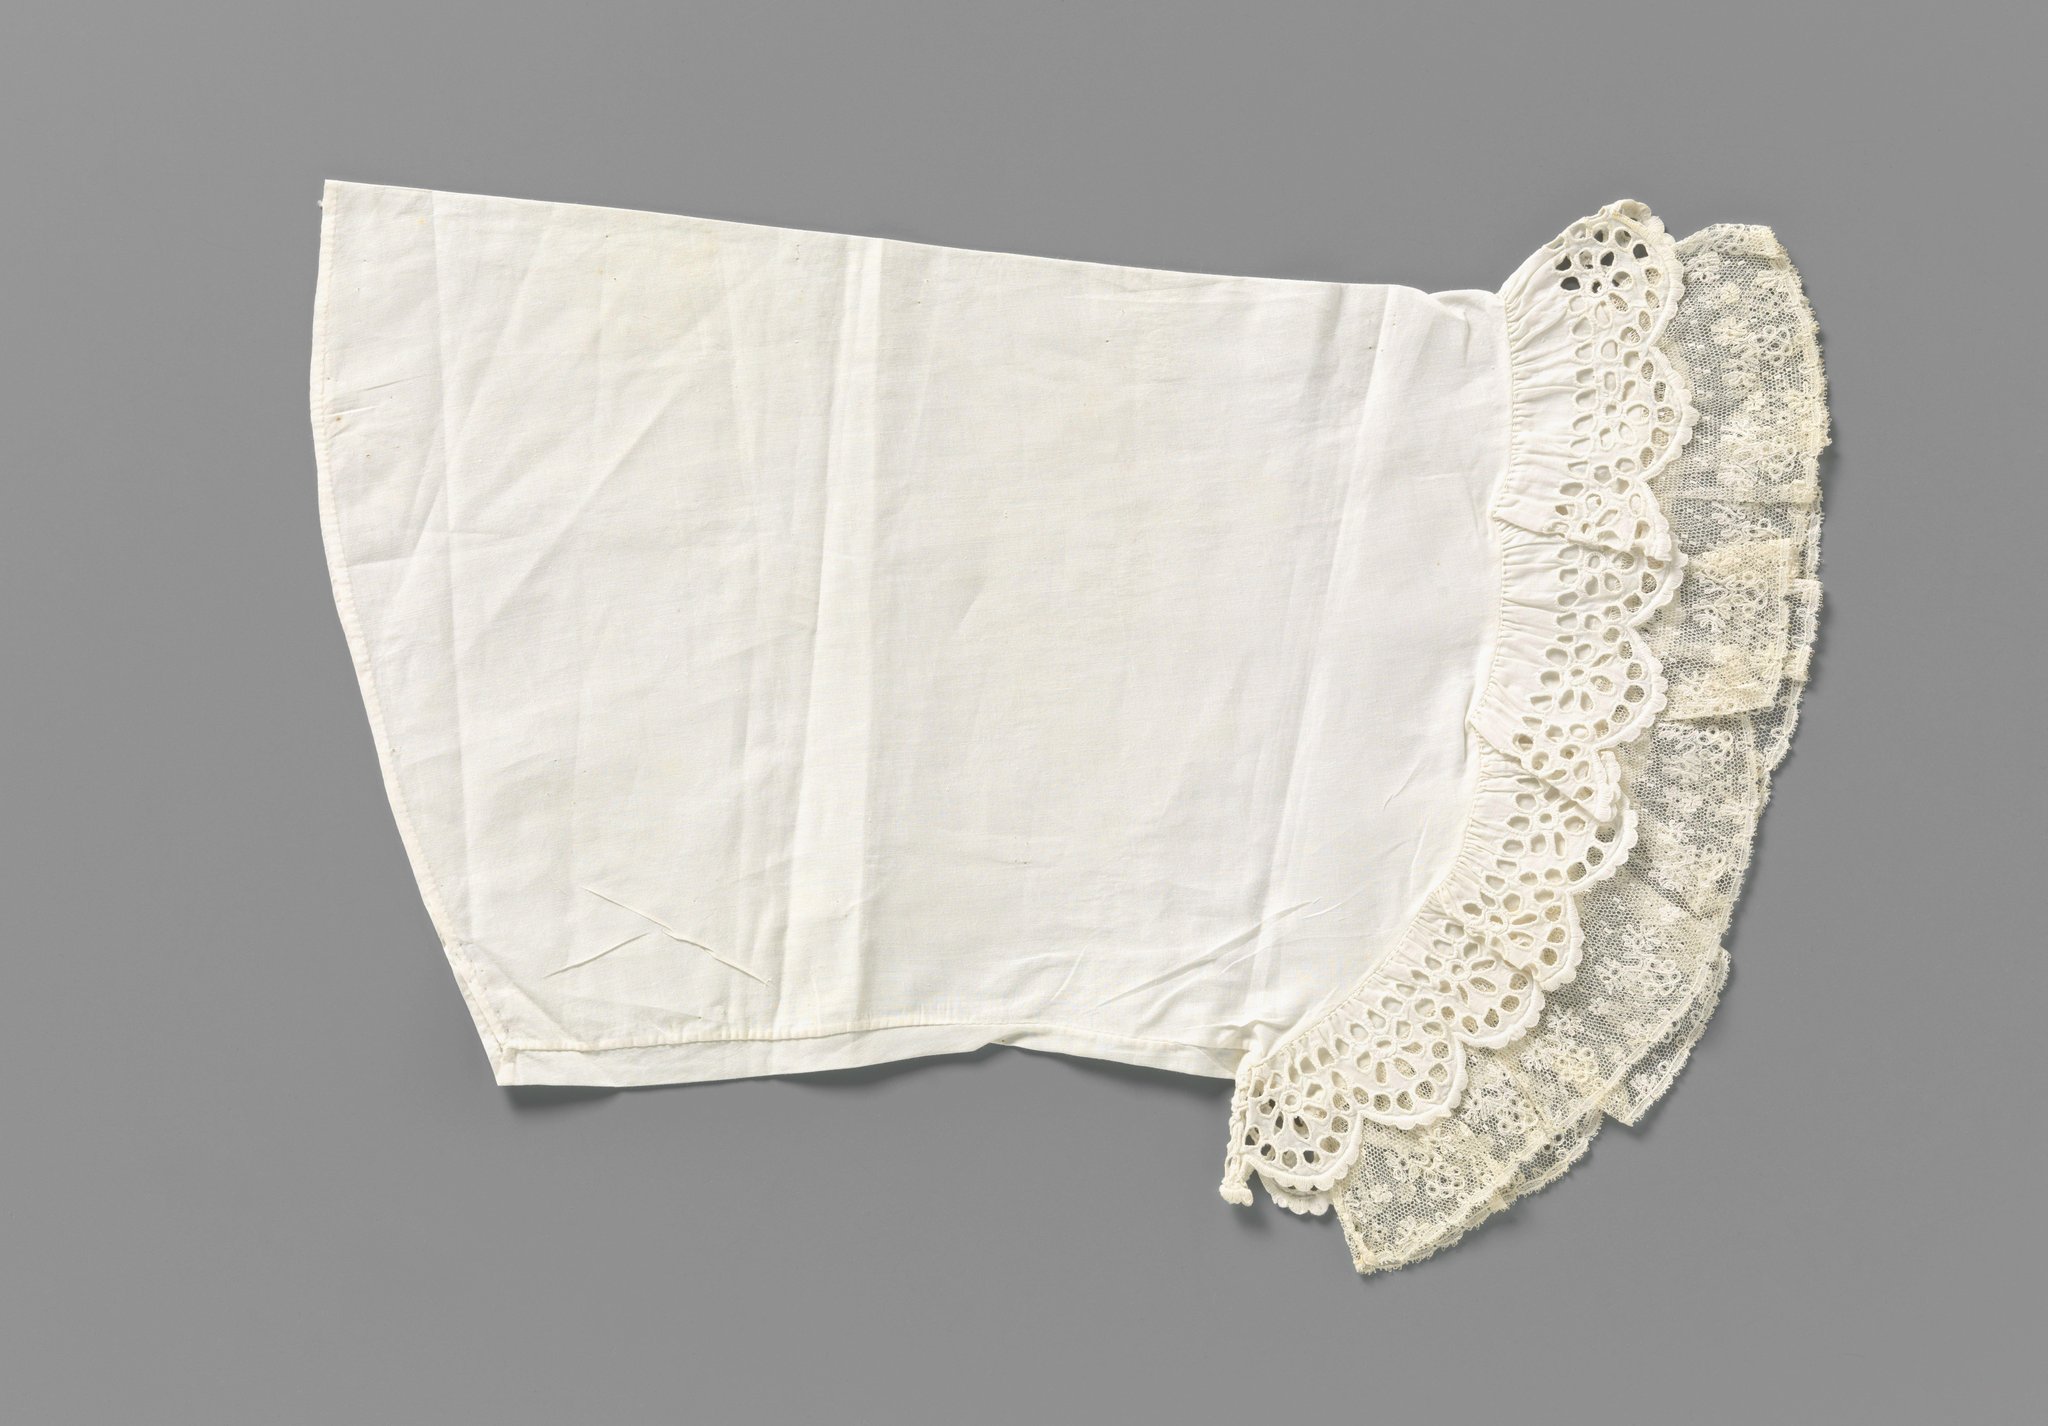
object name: pagoda sleeve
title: Pagodemouw van batist afgezet met een rand kantborduurwerk en een rand kloskant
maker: Anonymous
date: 1860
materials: textile, cotton, linen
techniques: lace, weave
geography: western europe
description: Pagodemouw van naturelkleurig batist afgewerkt met een strook kantborduurwerk - Engels borduurwerk - en een strook kloskant: Rijselse kant. De strook Engels borduurwerk valt deels over de rand kloskant.